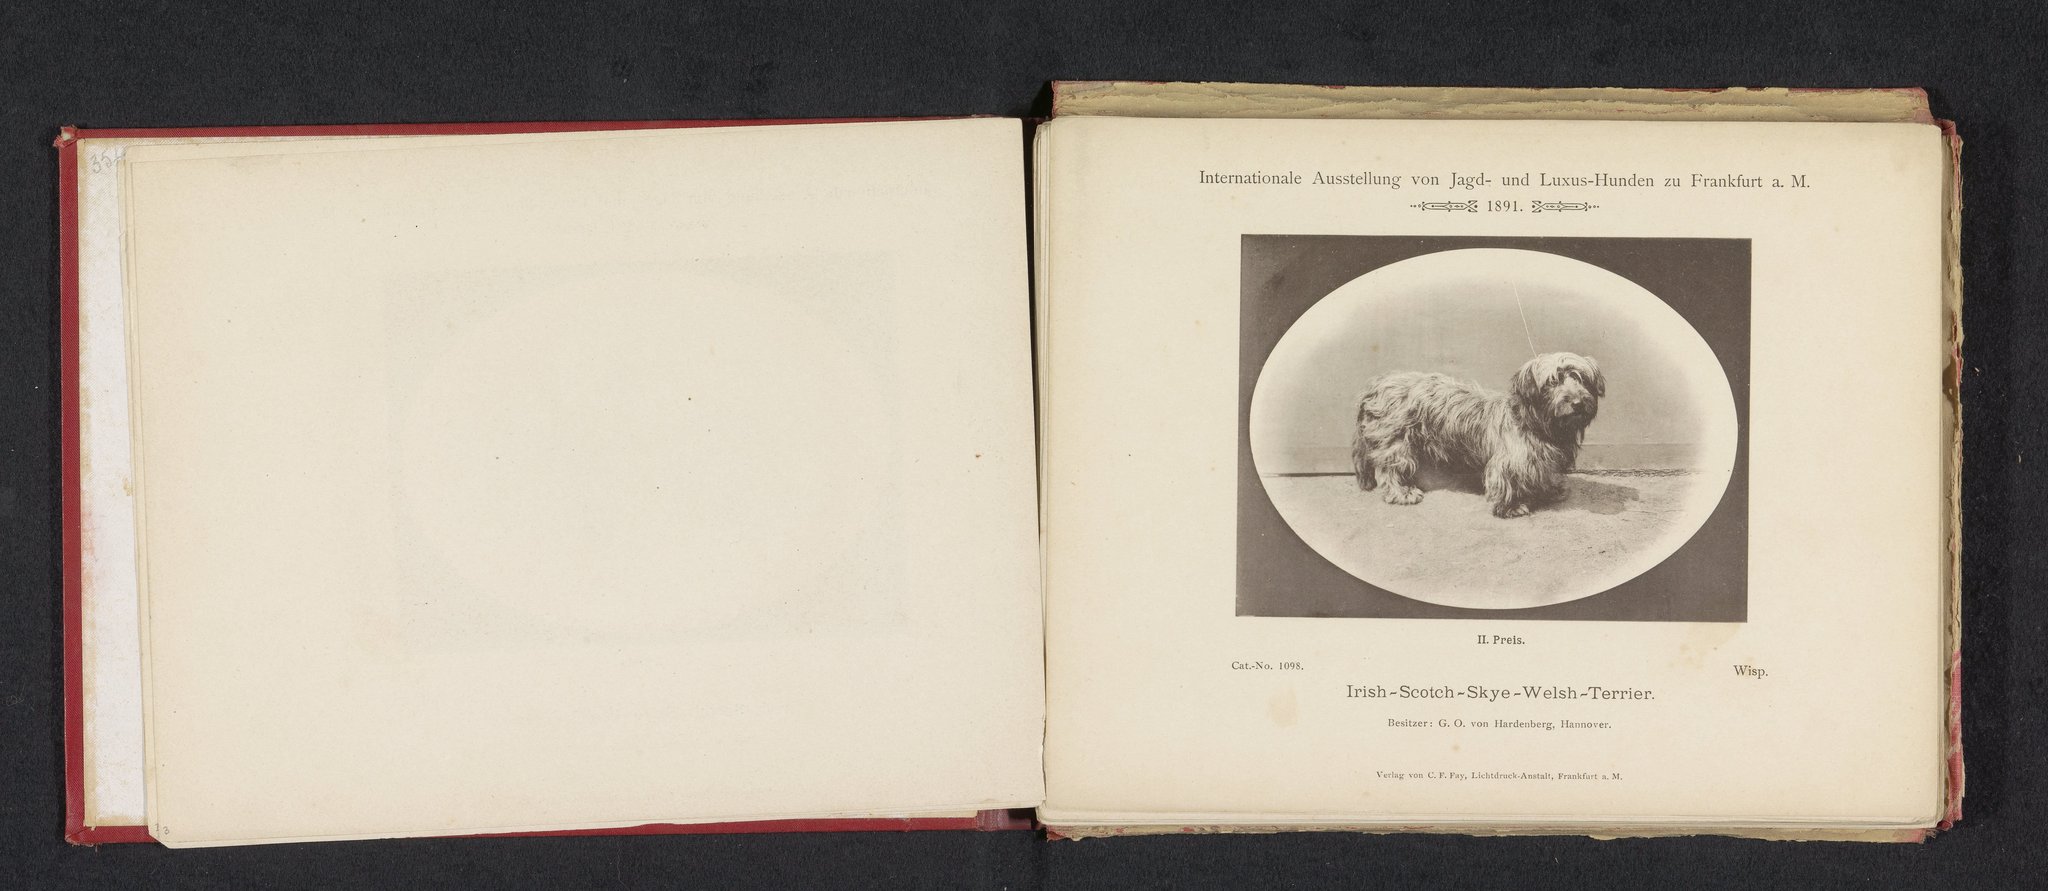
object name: page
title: Irish-Skotch-Skye-Welsh-Terrier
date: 1891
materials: paper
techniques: photograph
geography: frankfurt am main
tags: dog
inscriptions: number: ‘Cat.-No. 1098.’, inscription: ‘II. Preis. Wisp. Besitzer : G.O. von Hardenberg, Hannover.’